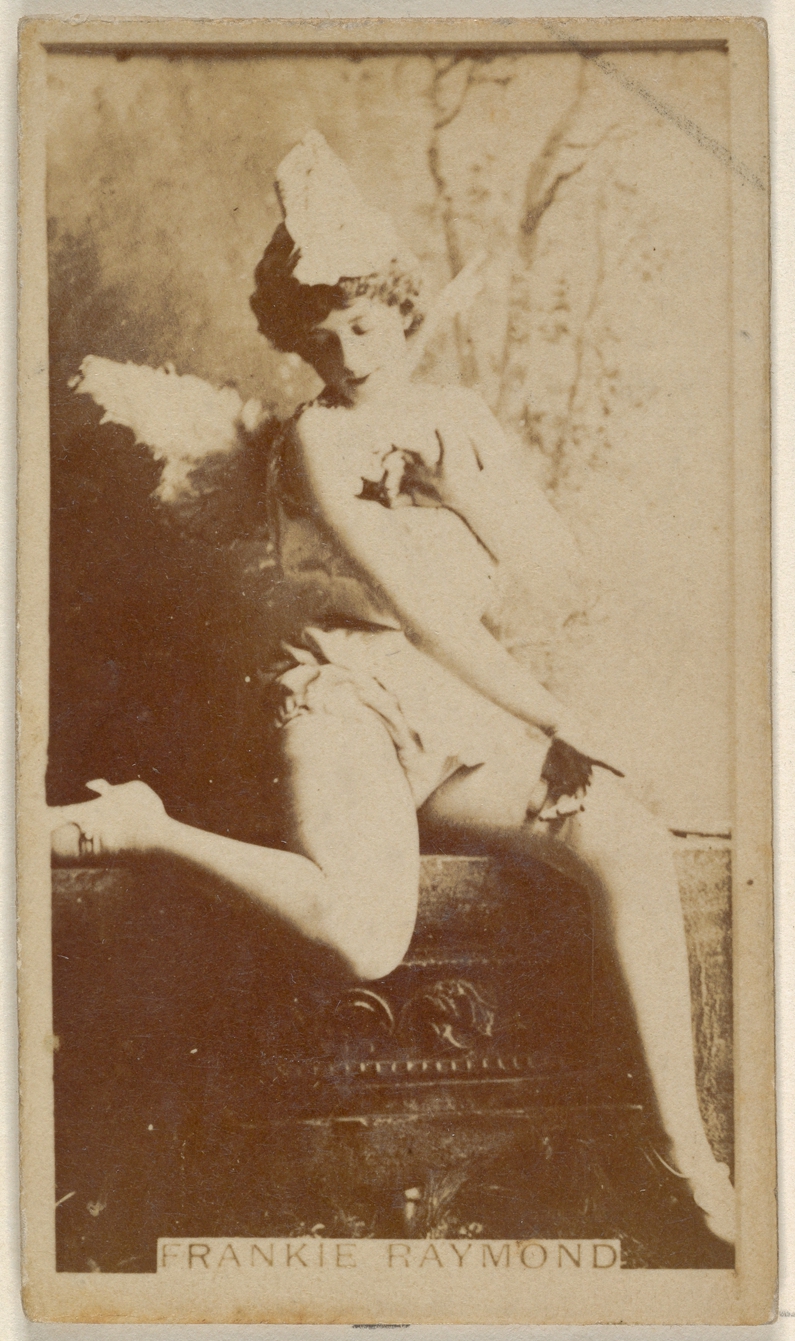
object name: photograph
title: Frankie Raymond, from the Actors and Actresses series (N45, Type 8) for Virginia Brights Cigarettes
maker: allen & ginter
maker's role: publisher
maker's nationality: american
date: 1888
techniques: albumen silver print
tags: portraits,women,actresses